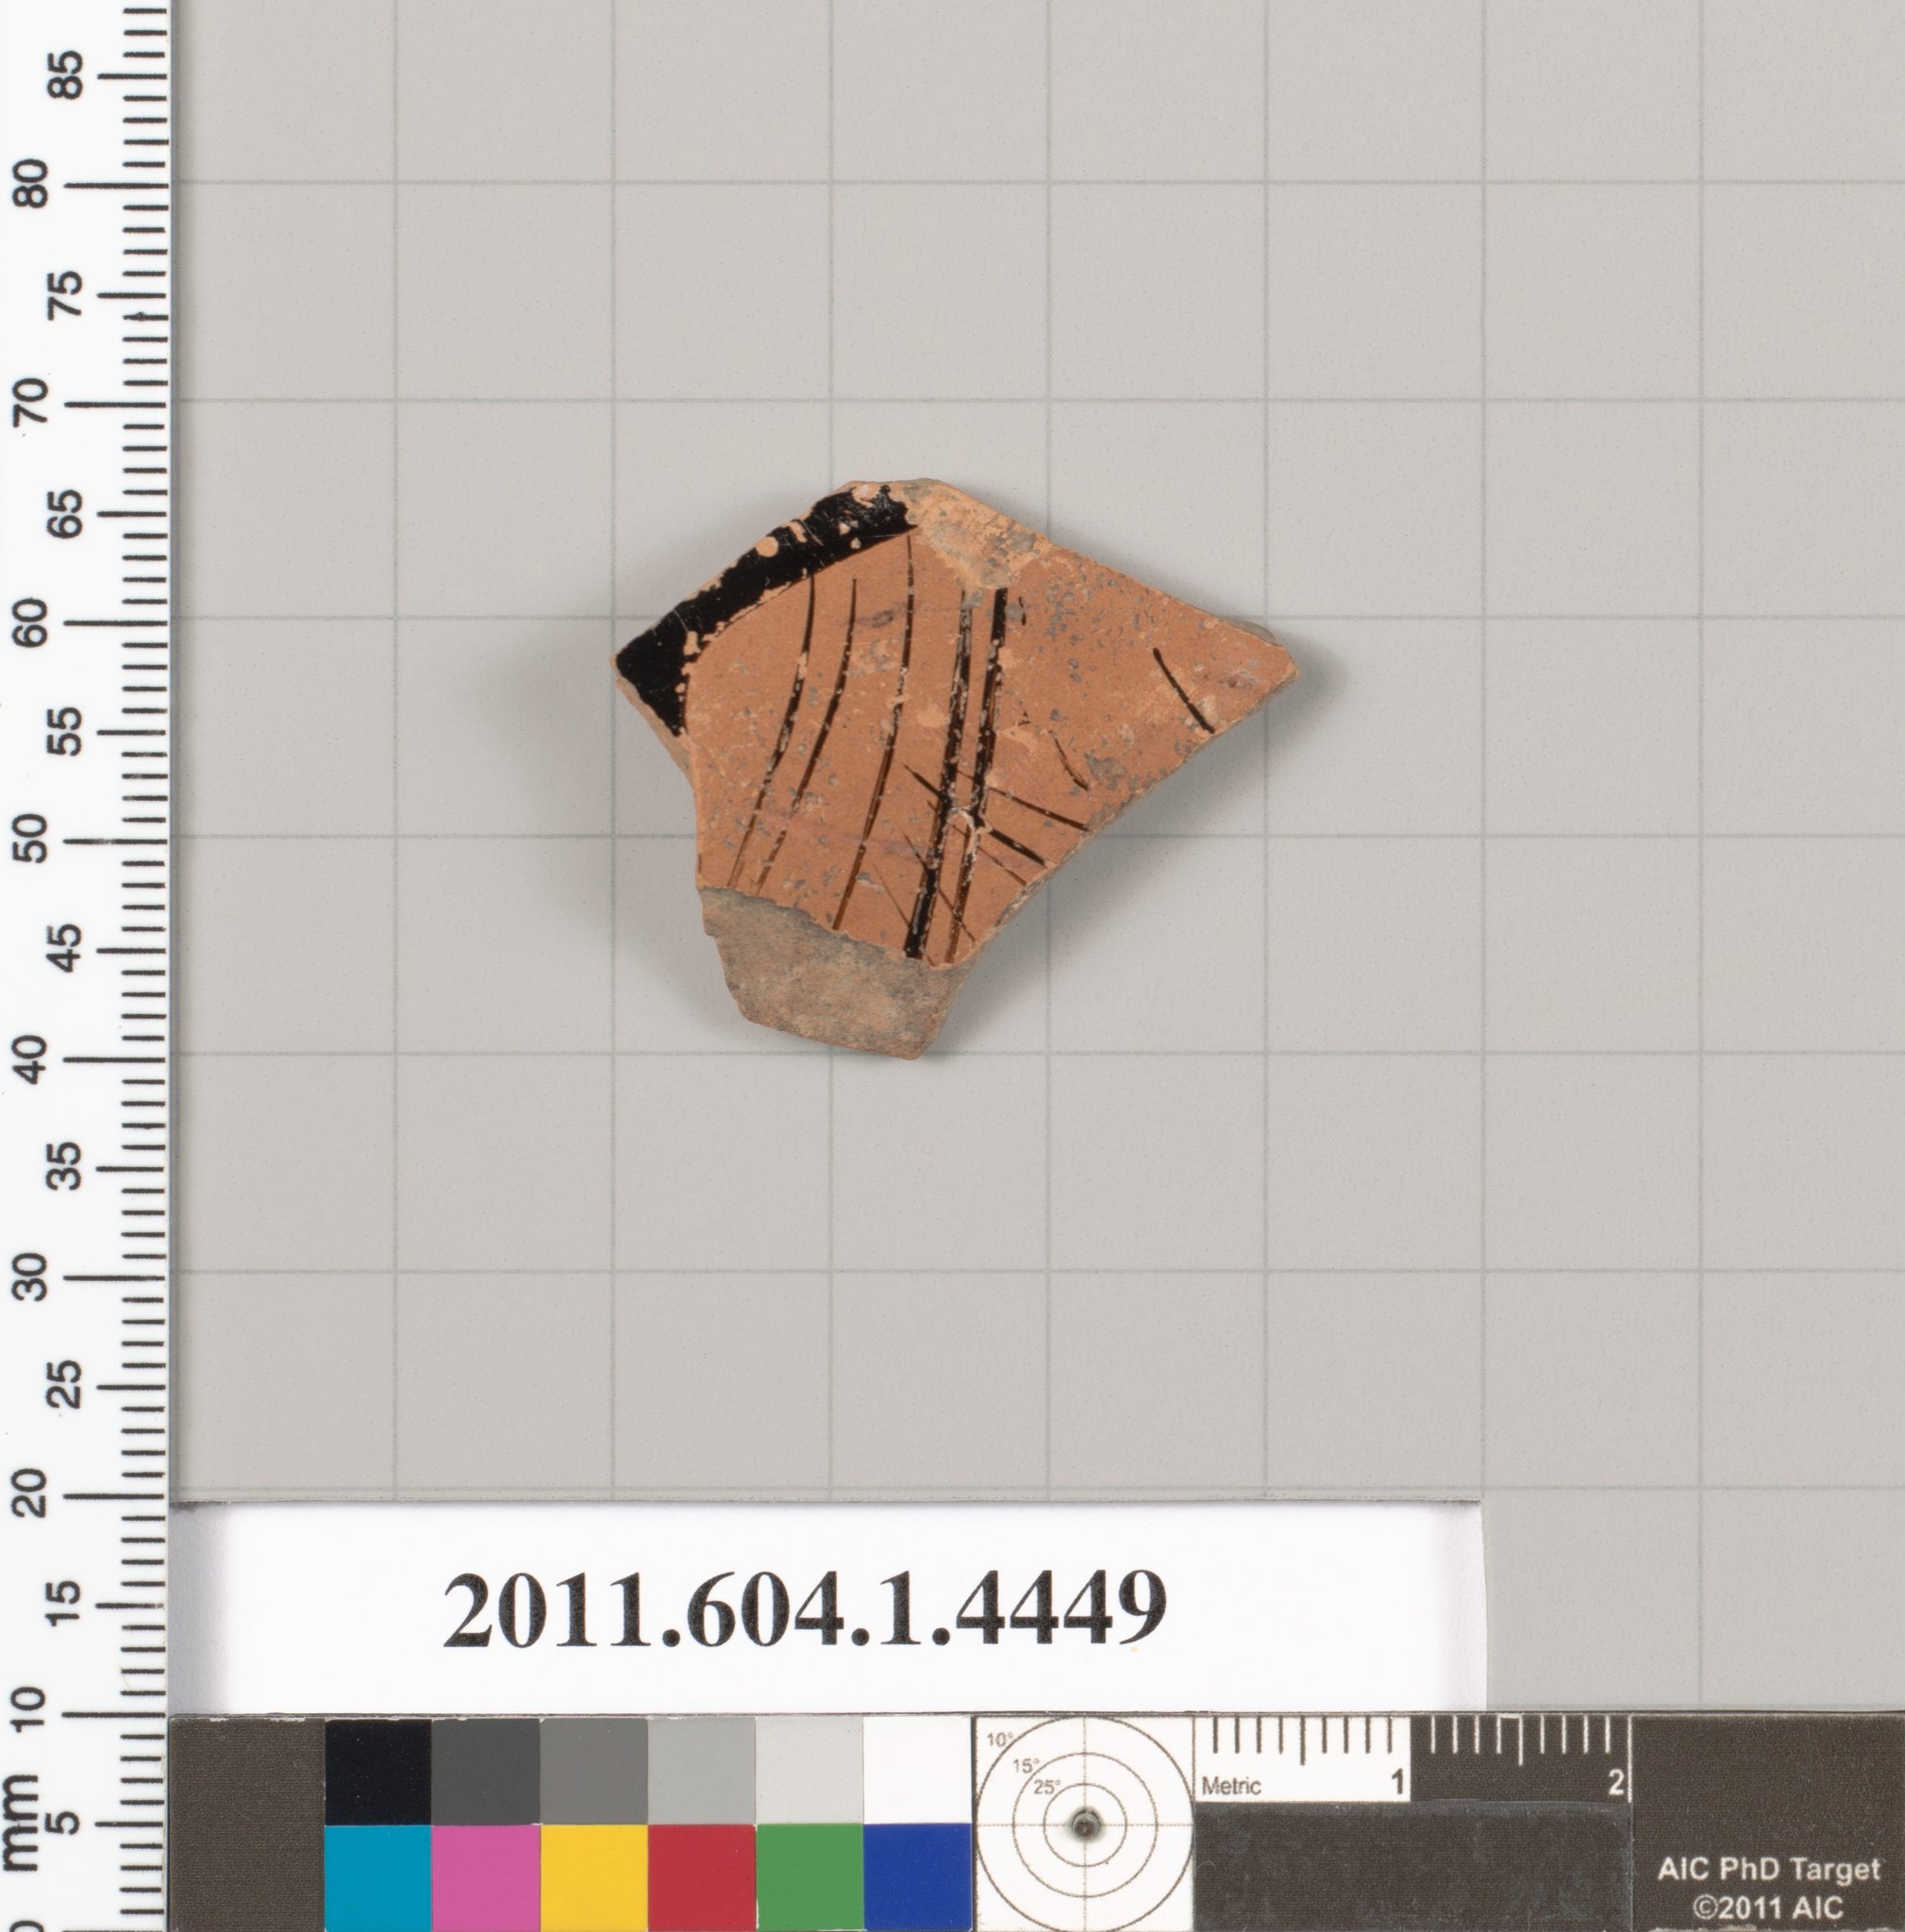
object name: kylix fragment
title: Terracotta fragment of a kylix (drinking cup)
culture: greek, attic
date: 475-451 BCE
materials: terracotta